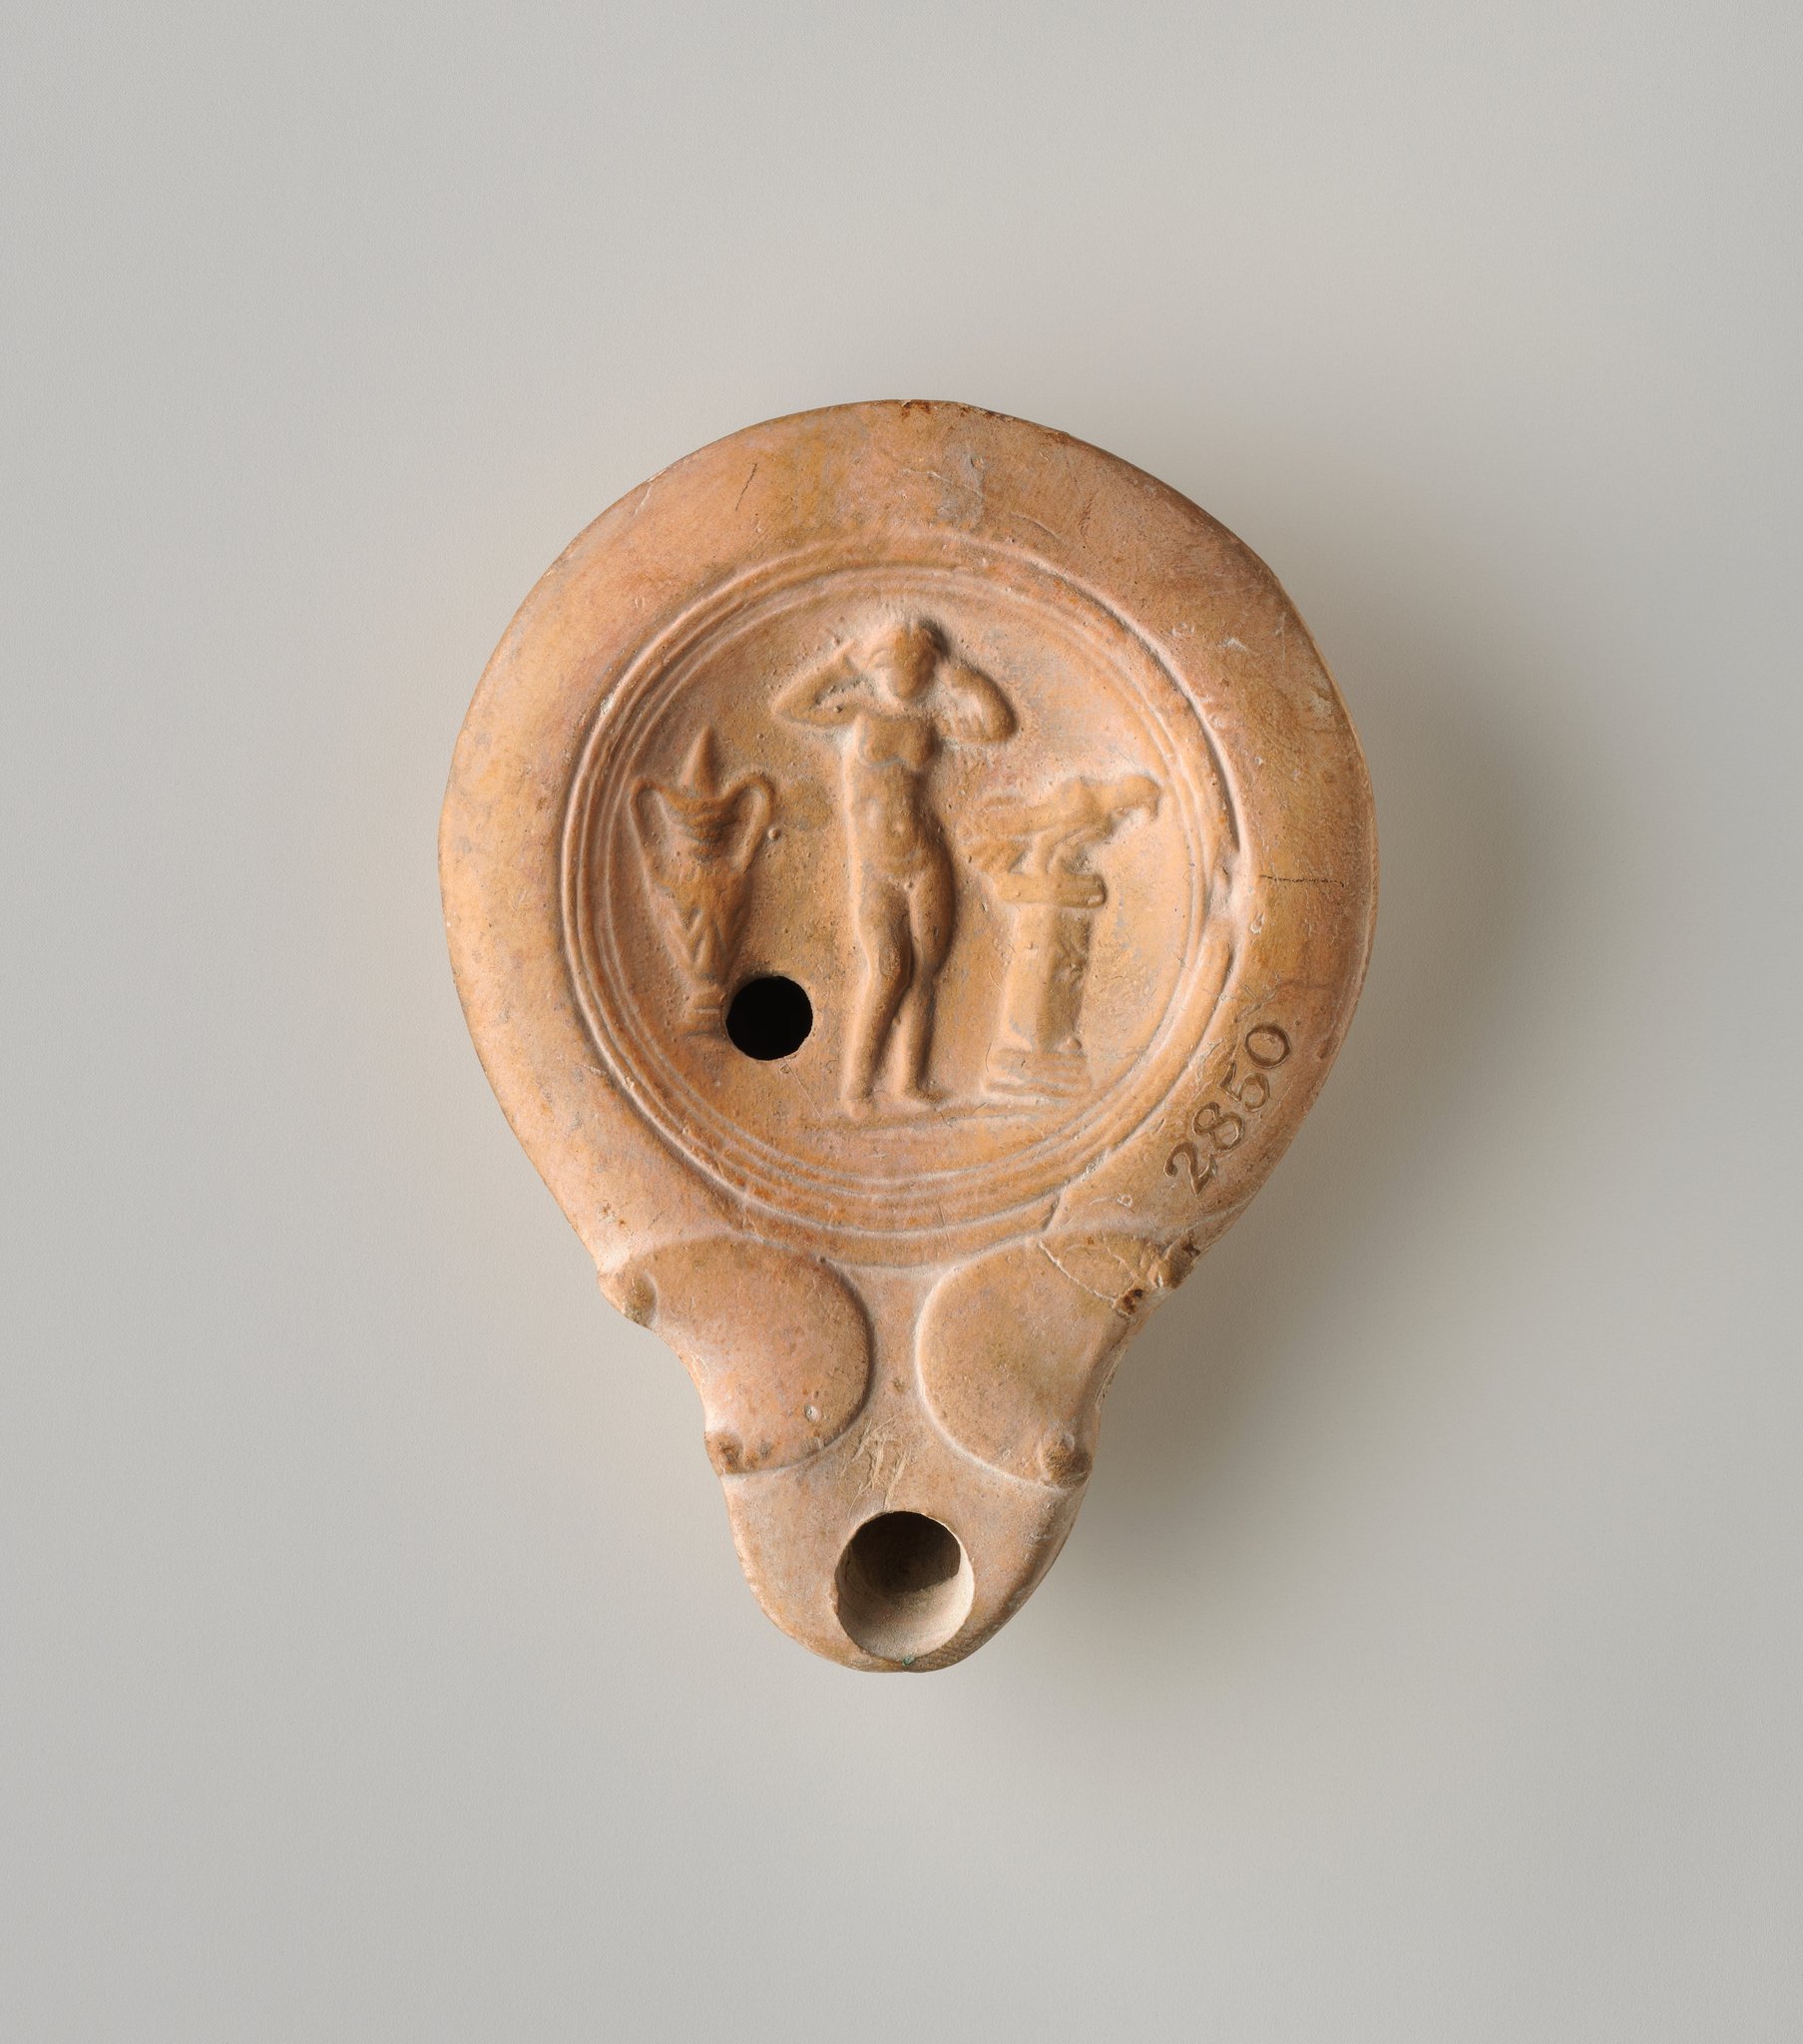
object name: lamp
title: Terracotta oil lamp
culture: roman, cnidian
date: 70-120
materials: terracotta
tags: birds,female nudes